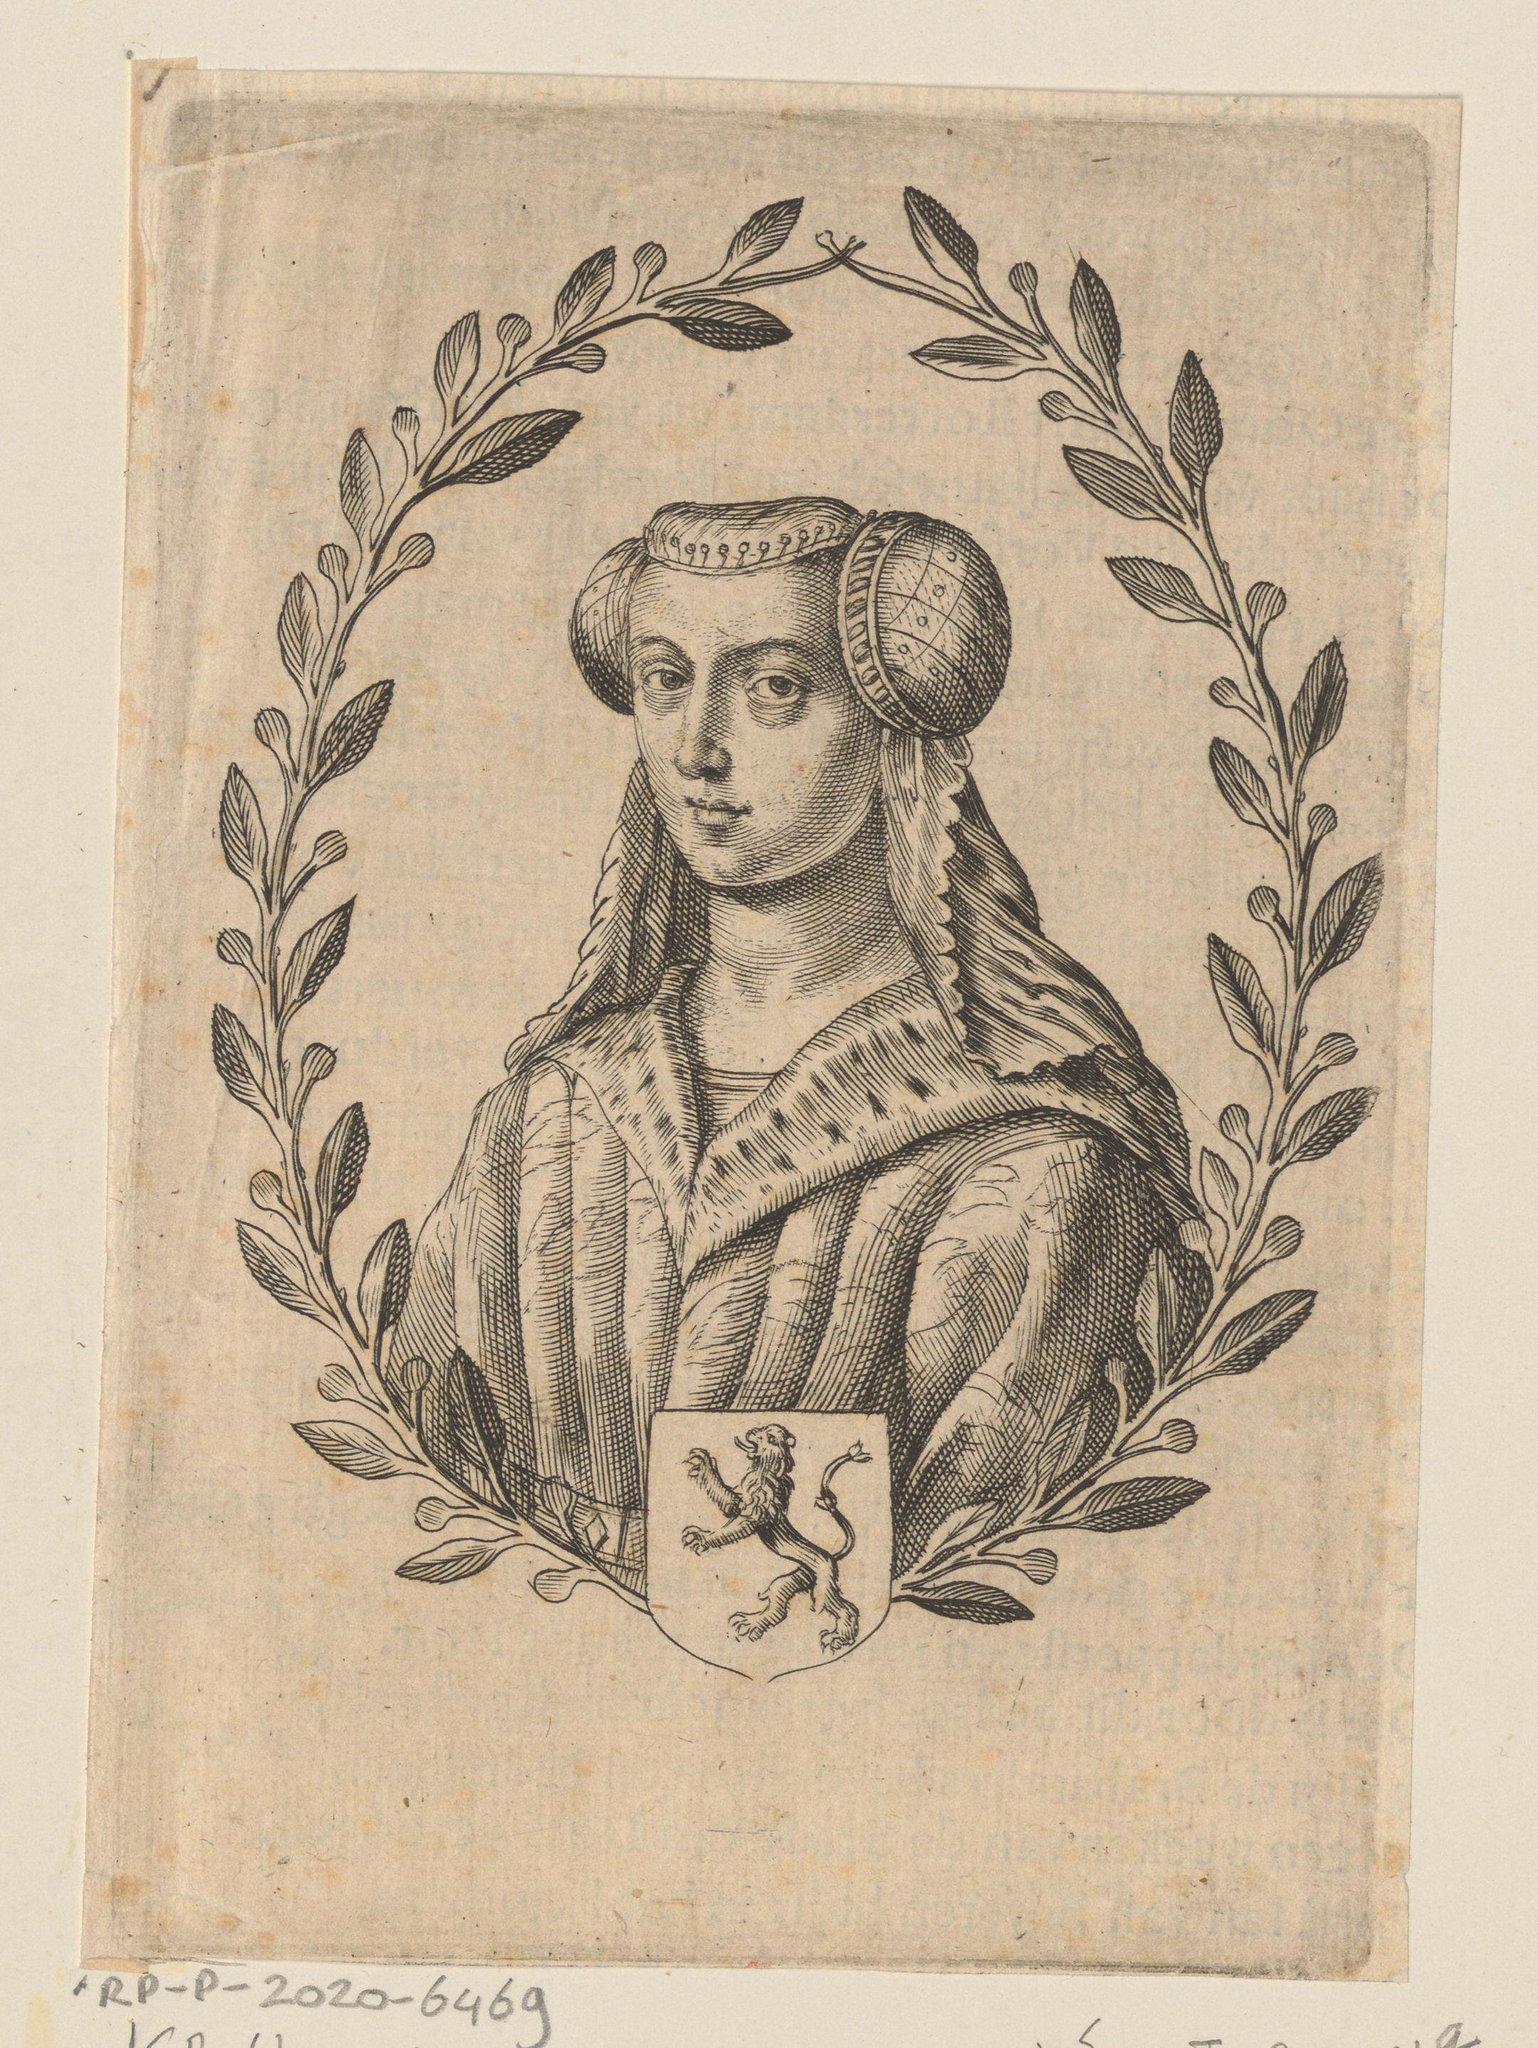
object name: print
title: Portret van Jacoba van Beieren, gravin van Holland, Zeeland en Henegouwen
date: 1645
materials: paper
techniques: engraving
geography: amsterdam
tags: jacoba of bavaria (countess of hainaut), historical persons - bb - woman, ruler, sovereign - bb - female ruler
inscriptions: collector's mark: Lugt 240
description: Prent uit: Wachtendorp, Caspar. Oude Hollandsche geschiedenissen ofte, korte Hollandtsche rym-kronyck. 14 dln. Amsterdam: Johannes Pauli, 1645, dl. 8.